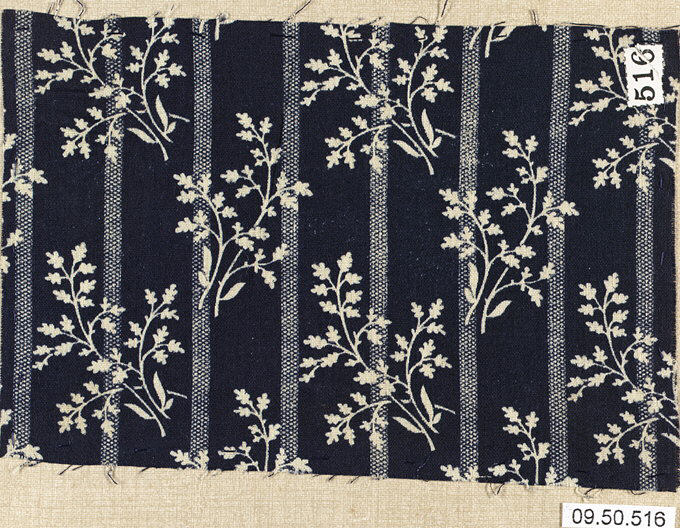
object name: piece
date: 1801-1900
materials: cotton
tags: leaves